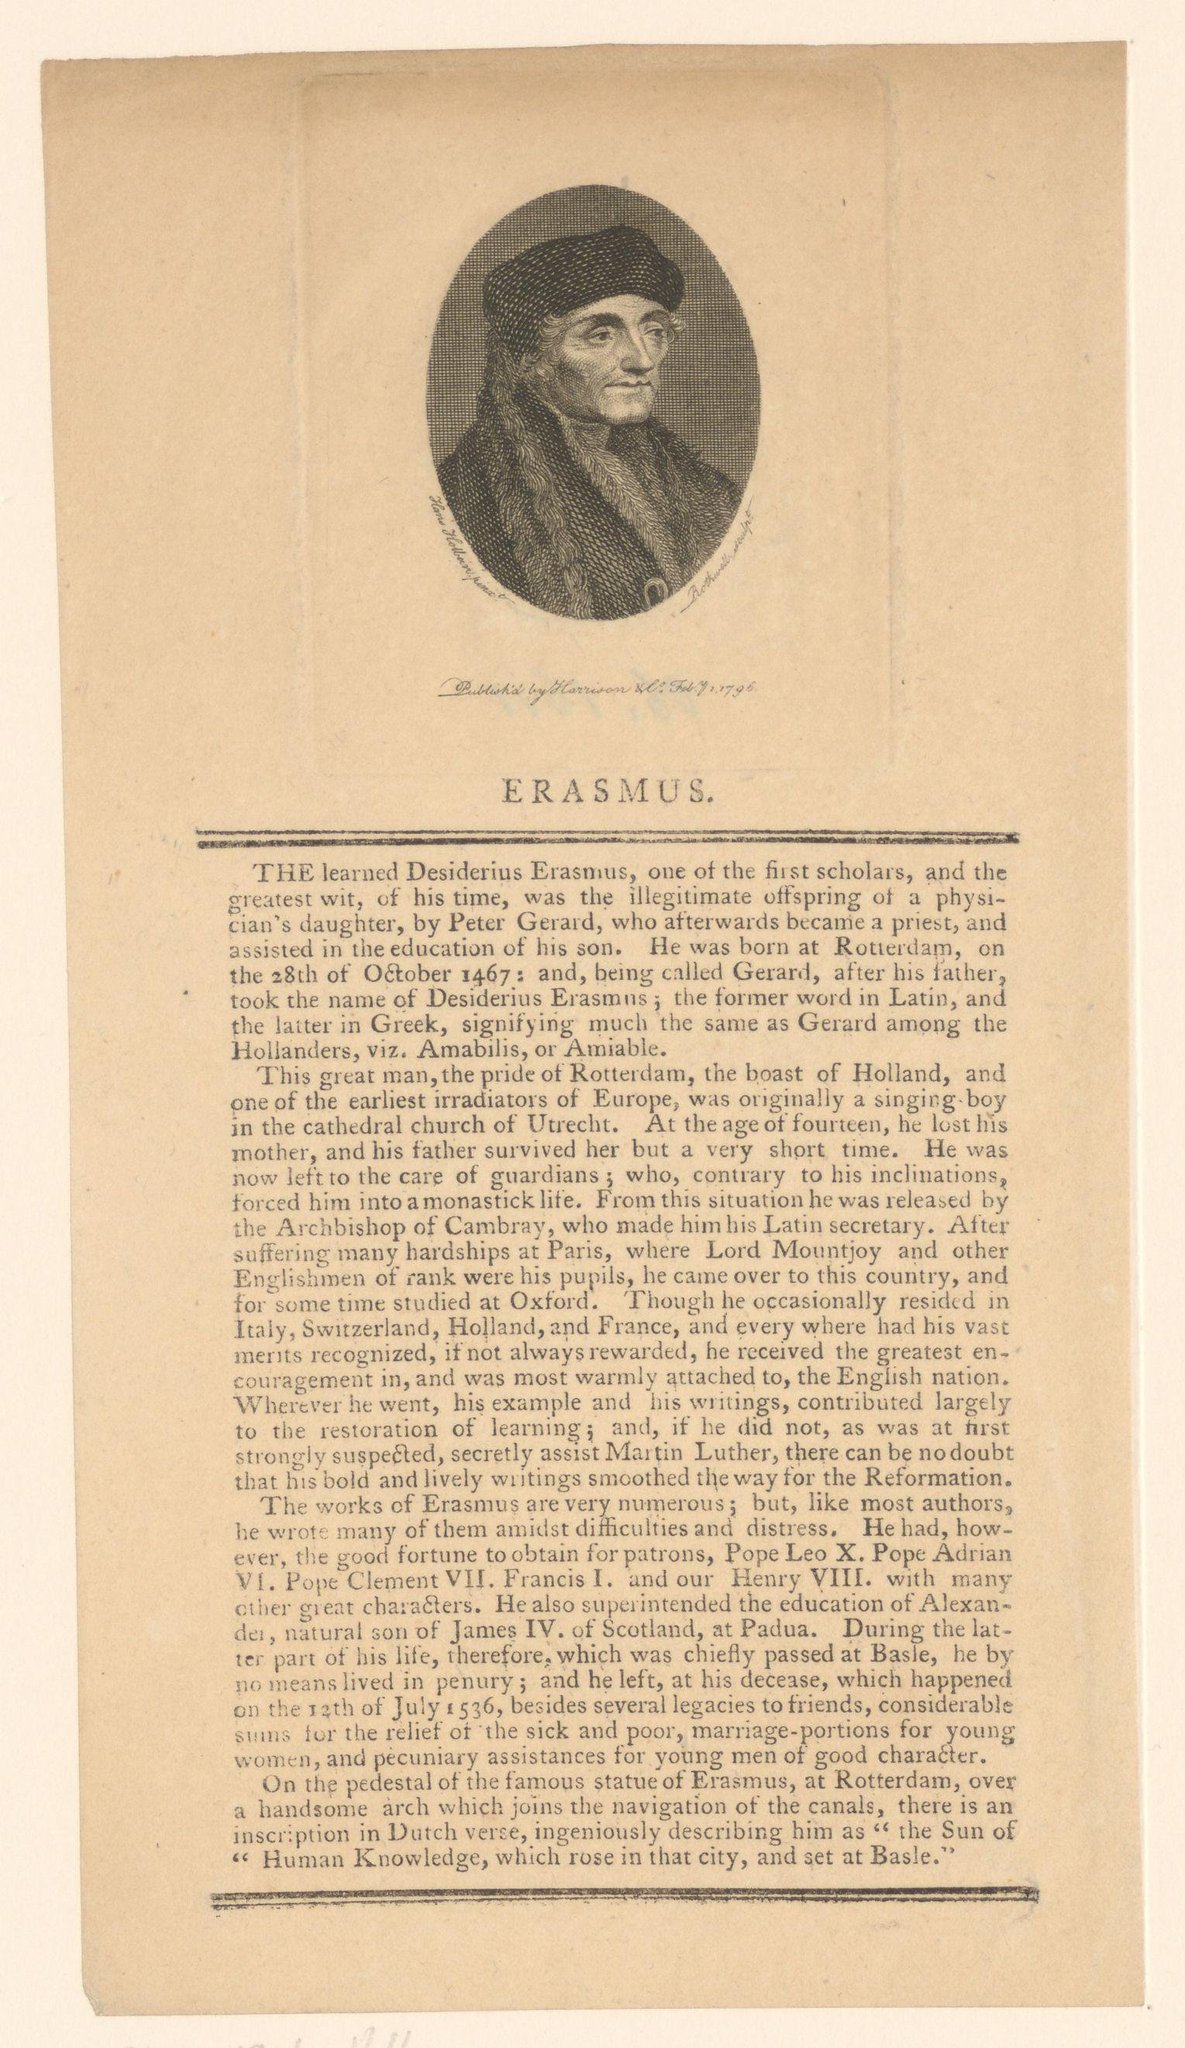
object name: print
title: Portret van Desiderius Erasmus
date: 1796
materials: paper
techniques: engraving, letterpress printing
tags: rotterdam, desiderius erasmus, historical persons, scholar, philosopher (+ portrait of scholar, scientist)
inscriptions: collector's mark: Lugt 2228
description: Prent gebruikt in: Biographical Magazine (1796).